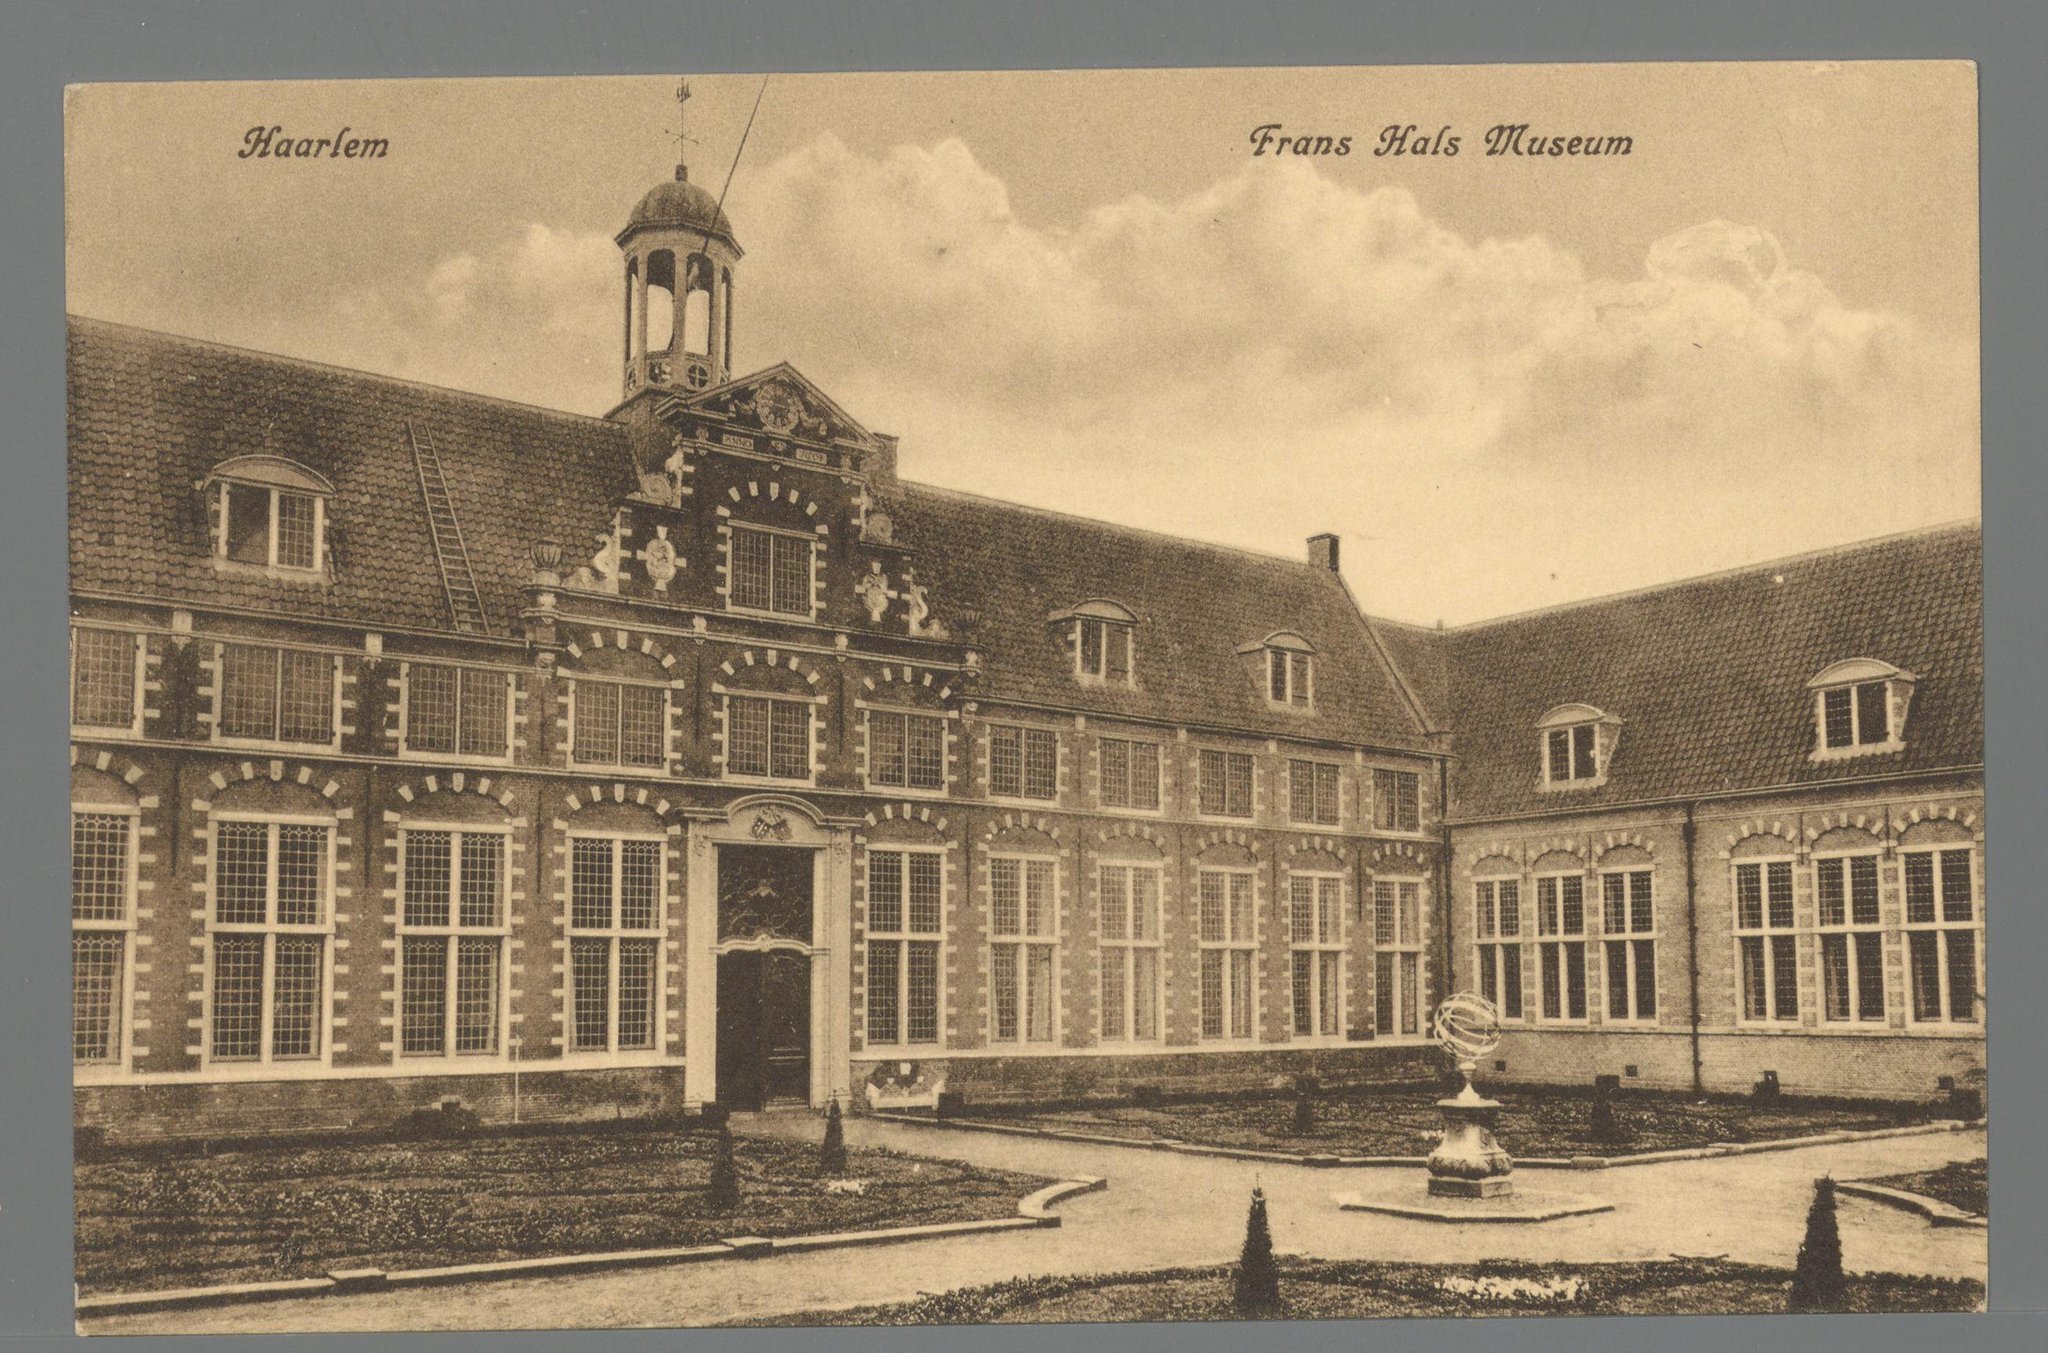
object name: ansichtkaart, prentbriefkaart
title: Haarlem. Frans Hals Museum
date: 1913-1930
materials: cardboard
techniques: photograph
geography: haarlem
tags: permanent exhibition, museum, haarlem